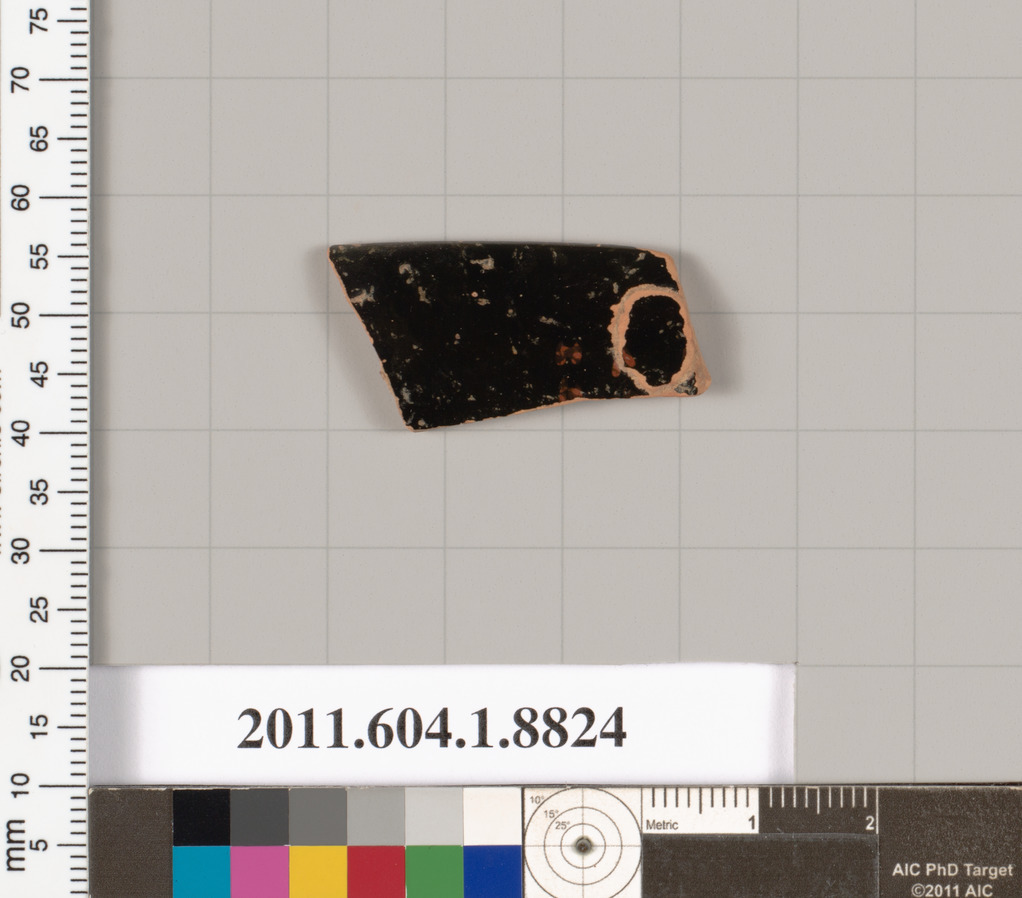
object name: kylix fragment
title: Terracotta rim fragment of a kylix (drinking cup)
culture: greek, attic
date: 490-480 BCE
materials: terracotta